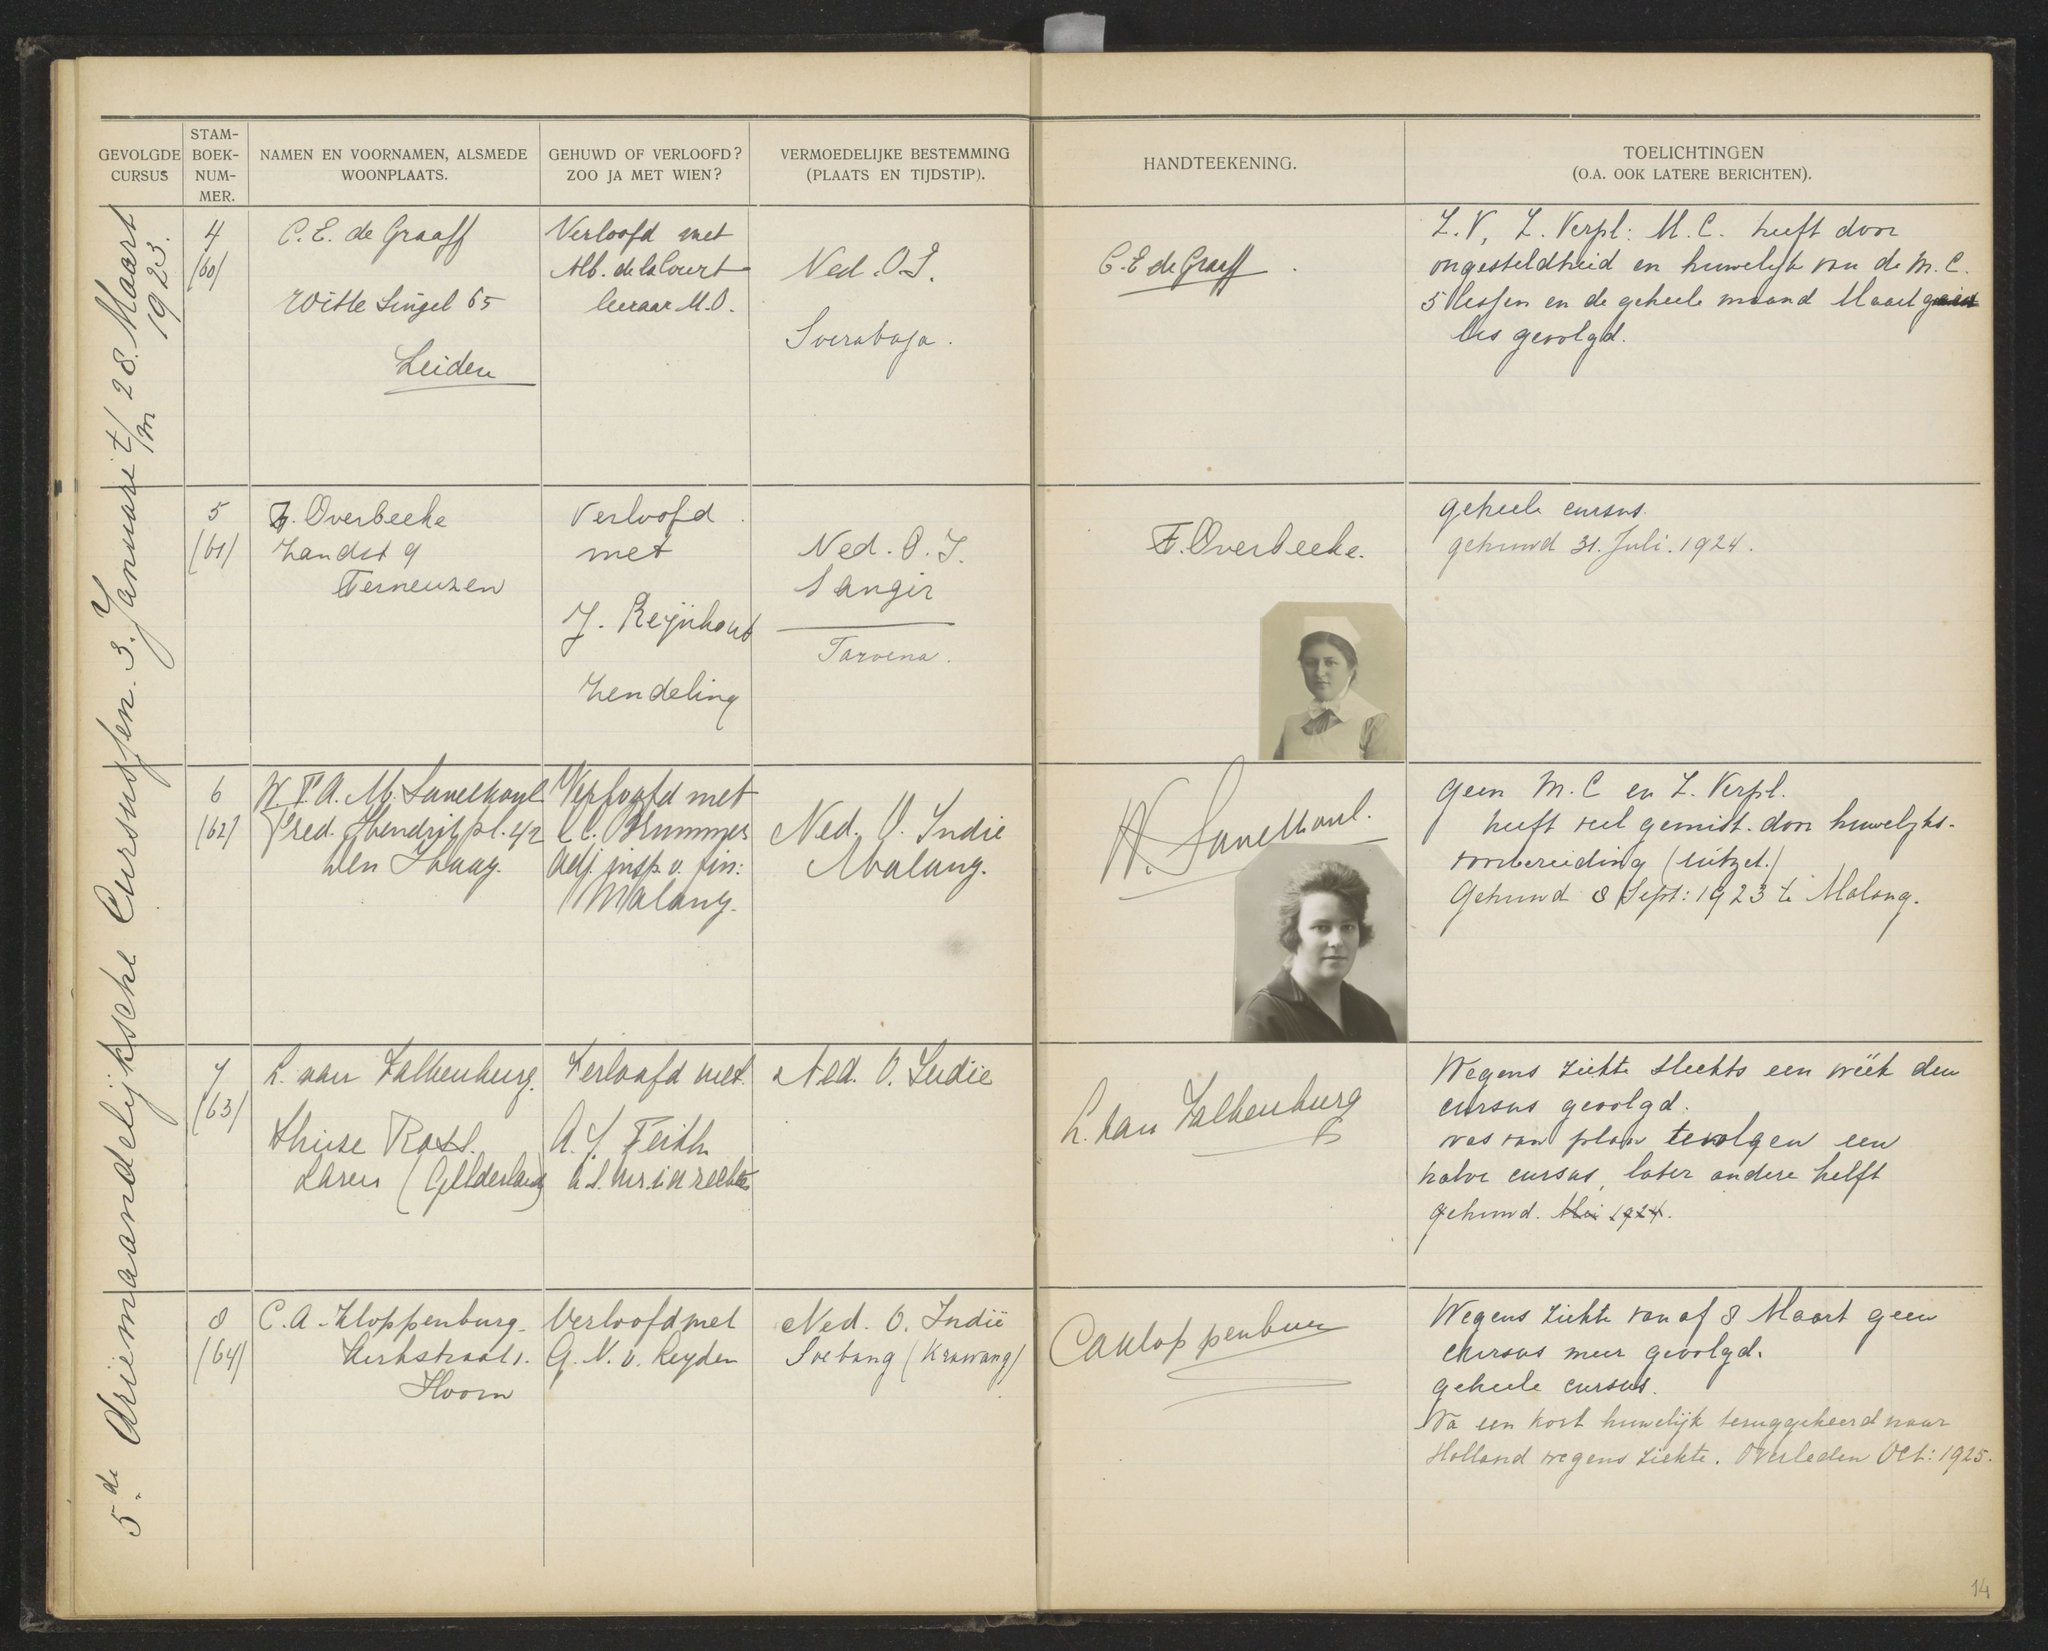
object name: photograph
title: Blad 14 uit Stamboek van de leerlingen der Koloniale School voor Meisjes en Vrouwen te 's-Gravenhage deel I (1921-1929)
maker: Anonymous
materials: paper, photographic support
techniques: photography, printing, writing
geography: the hague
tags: further education (+ pupil), further education, the hague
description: Twee pagina's met gegevens van de deelnemers aan de 5e driemaandelijkse cursus van 3 januari tot en met 28 maart 1923, stamboeknummers 60 tot en met 64. Onderdeel van Stamboek van de leerlingen der Koloniale School voor Meisjes en Vrouwen te 's-Gravenhage deel I (1921-1929).